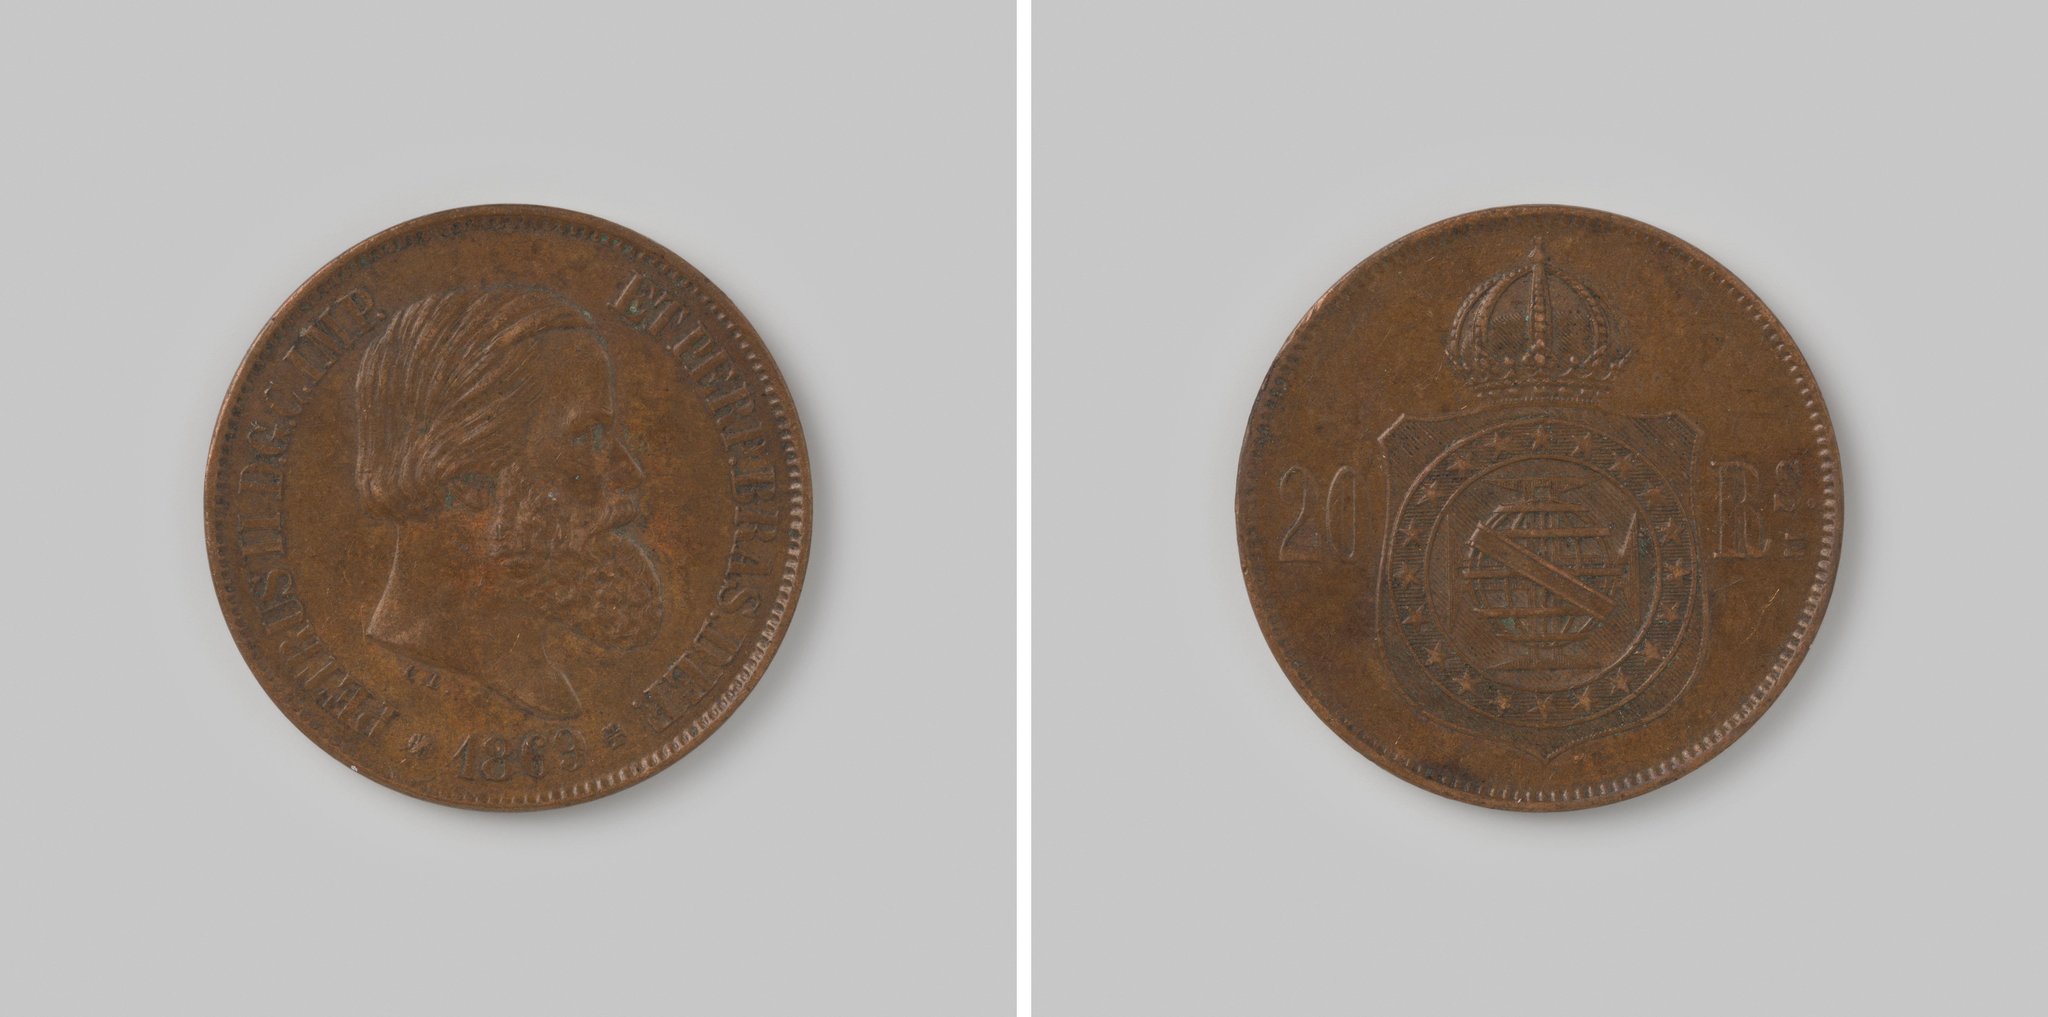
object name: coin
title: 20 reis van het keizerrijk Brazilië van D. Pedro II, 1868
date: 1868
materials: bronze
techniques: striking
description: Bronzen munt. Voorzijde: hoofd van de keizer naar rechts. In omschrift onderaan jaartal. Keerzijde: tussen waarde-aanduiding 20 Rs. gekroond wapenschild van Brazilië. Gladde rand.